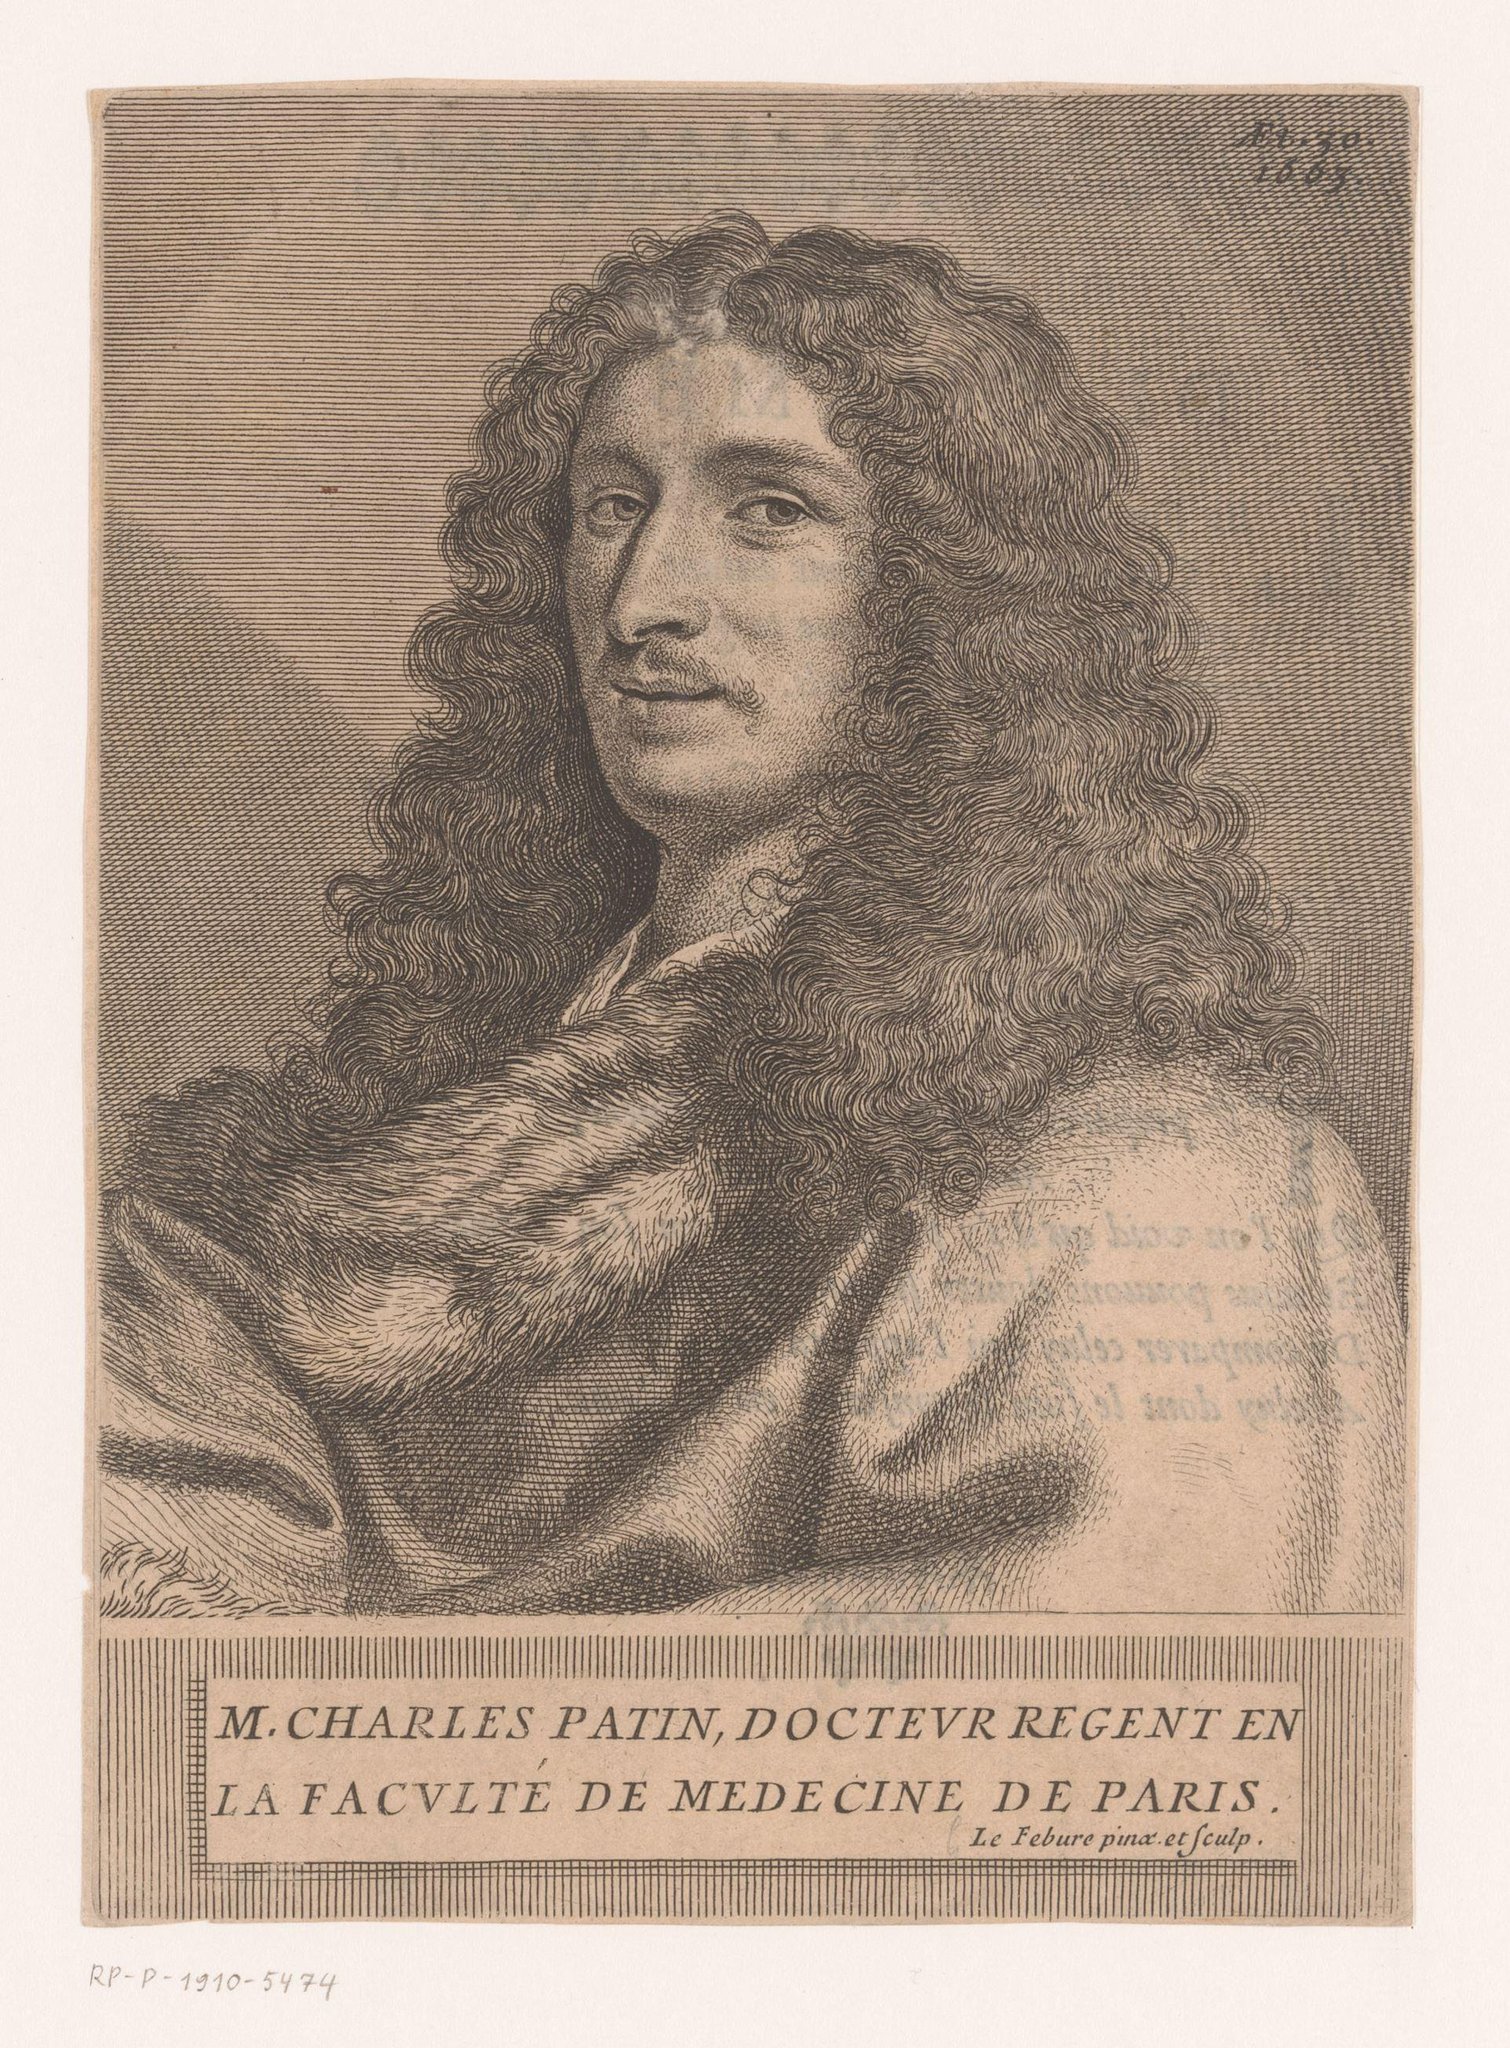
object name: print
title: Portret van Charles Patin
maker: claude lefèbvre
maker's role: painter, print maker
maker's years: 1632-1675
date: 1663-1675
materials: paper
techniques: engraving, etching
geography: france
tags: charles patin, historical persons, physician, doctor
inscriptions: collector's mark: Lugt 2228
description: Prent uit: Patin, Charles. Traité des tournes combustibles. Parijs: Du Bray et Variquet, 1663.